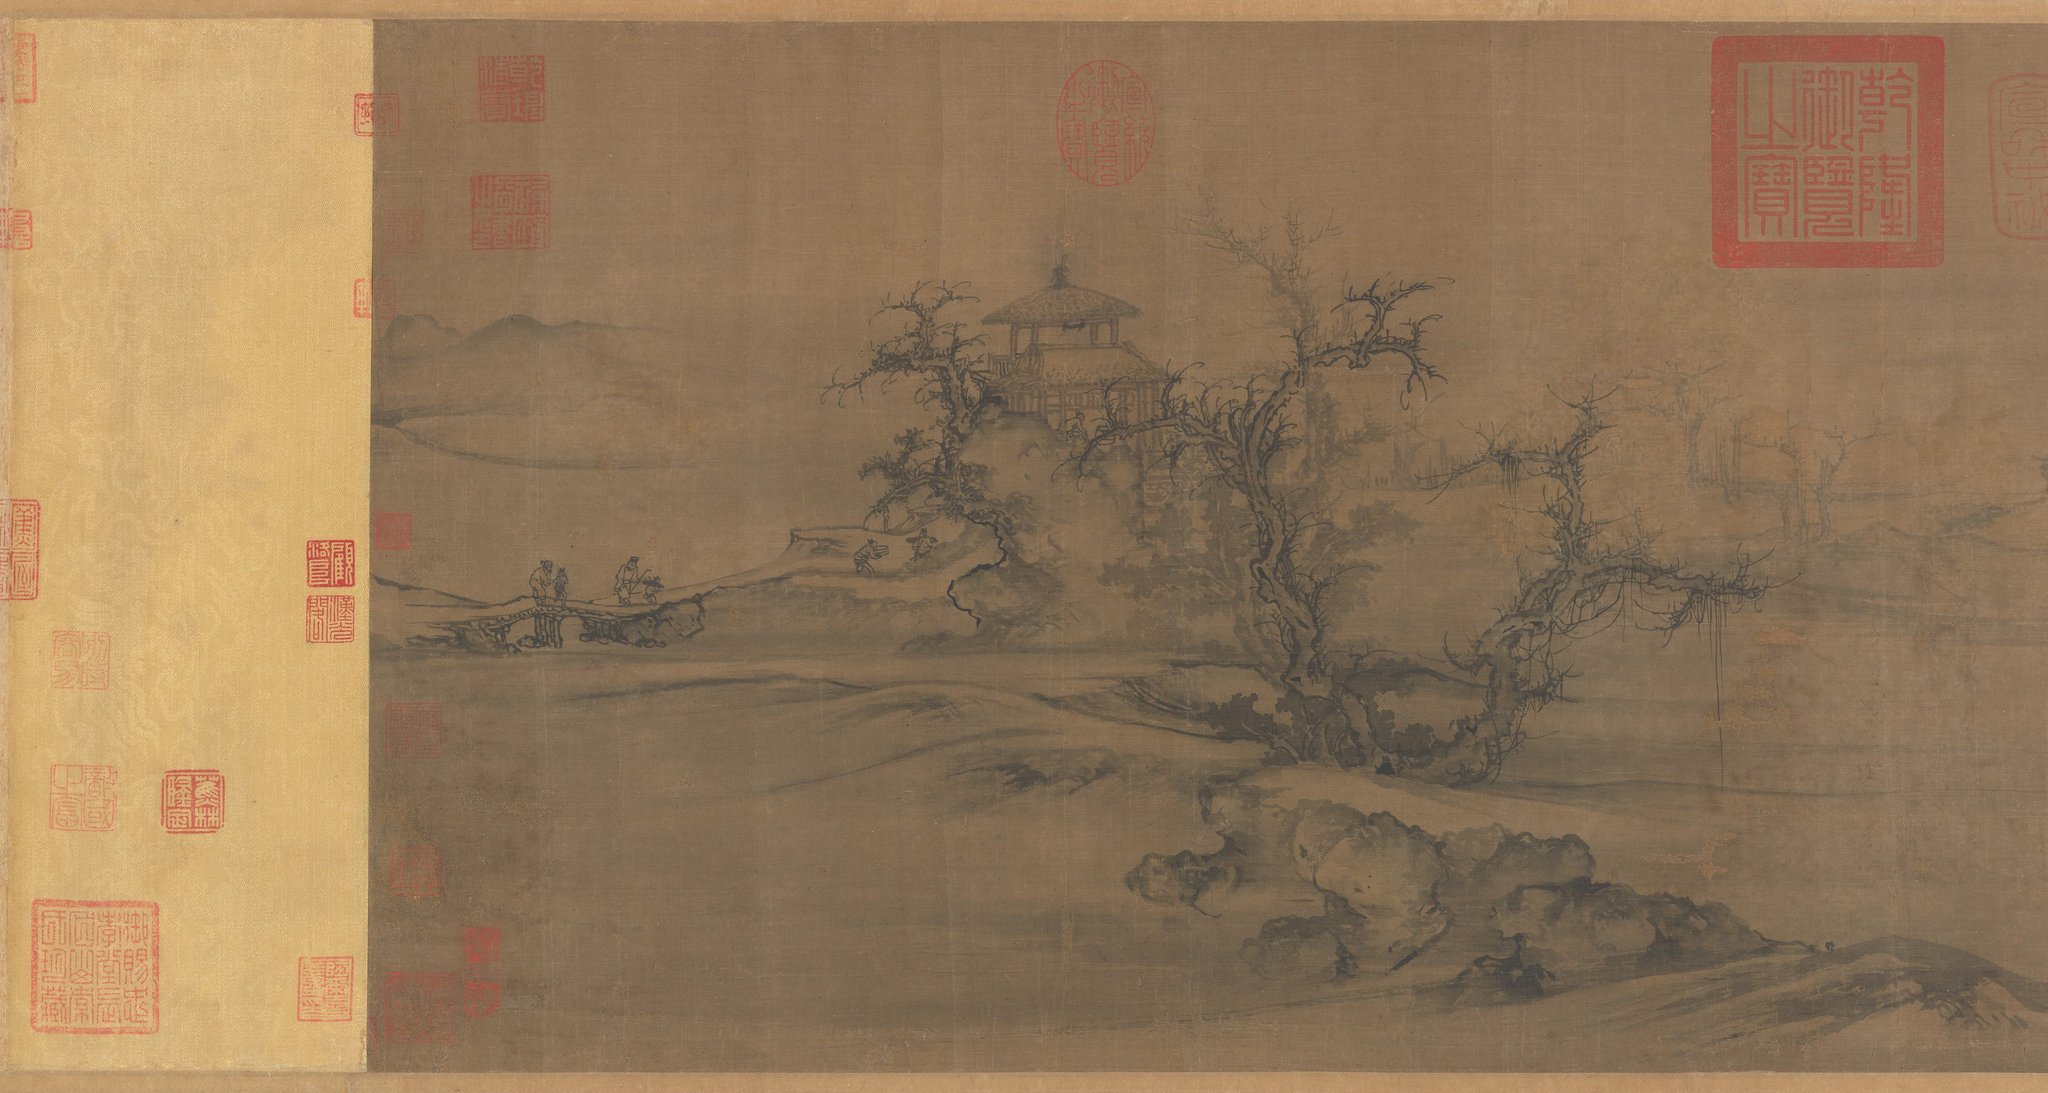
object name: handscroll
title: Old Trees, Level Distance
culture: chinese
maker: guo xi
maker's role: artist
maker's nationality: chinese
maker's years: 1000-1090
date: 1080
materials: ink, silk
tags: landscapes,trees